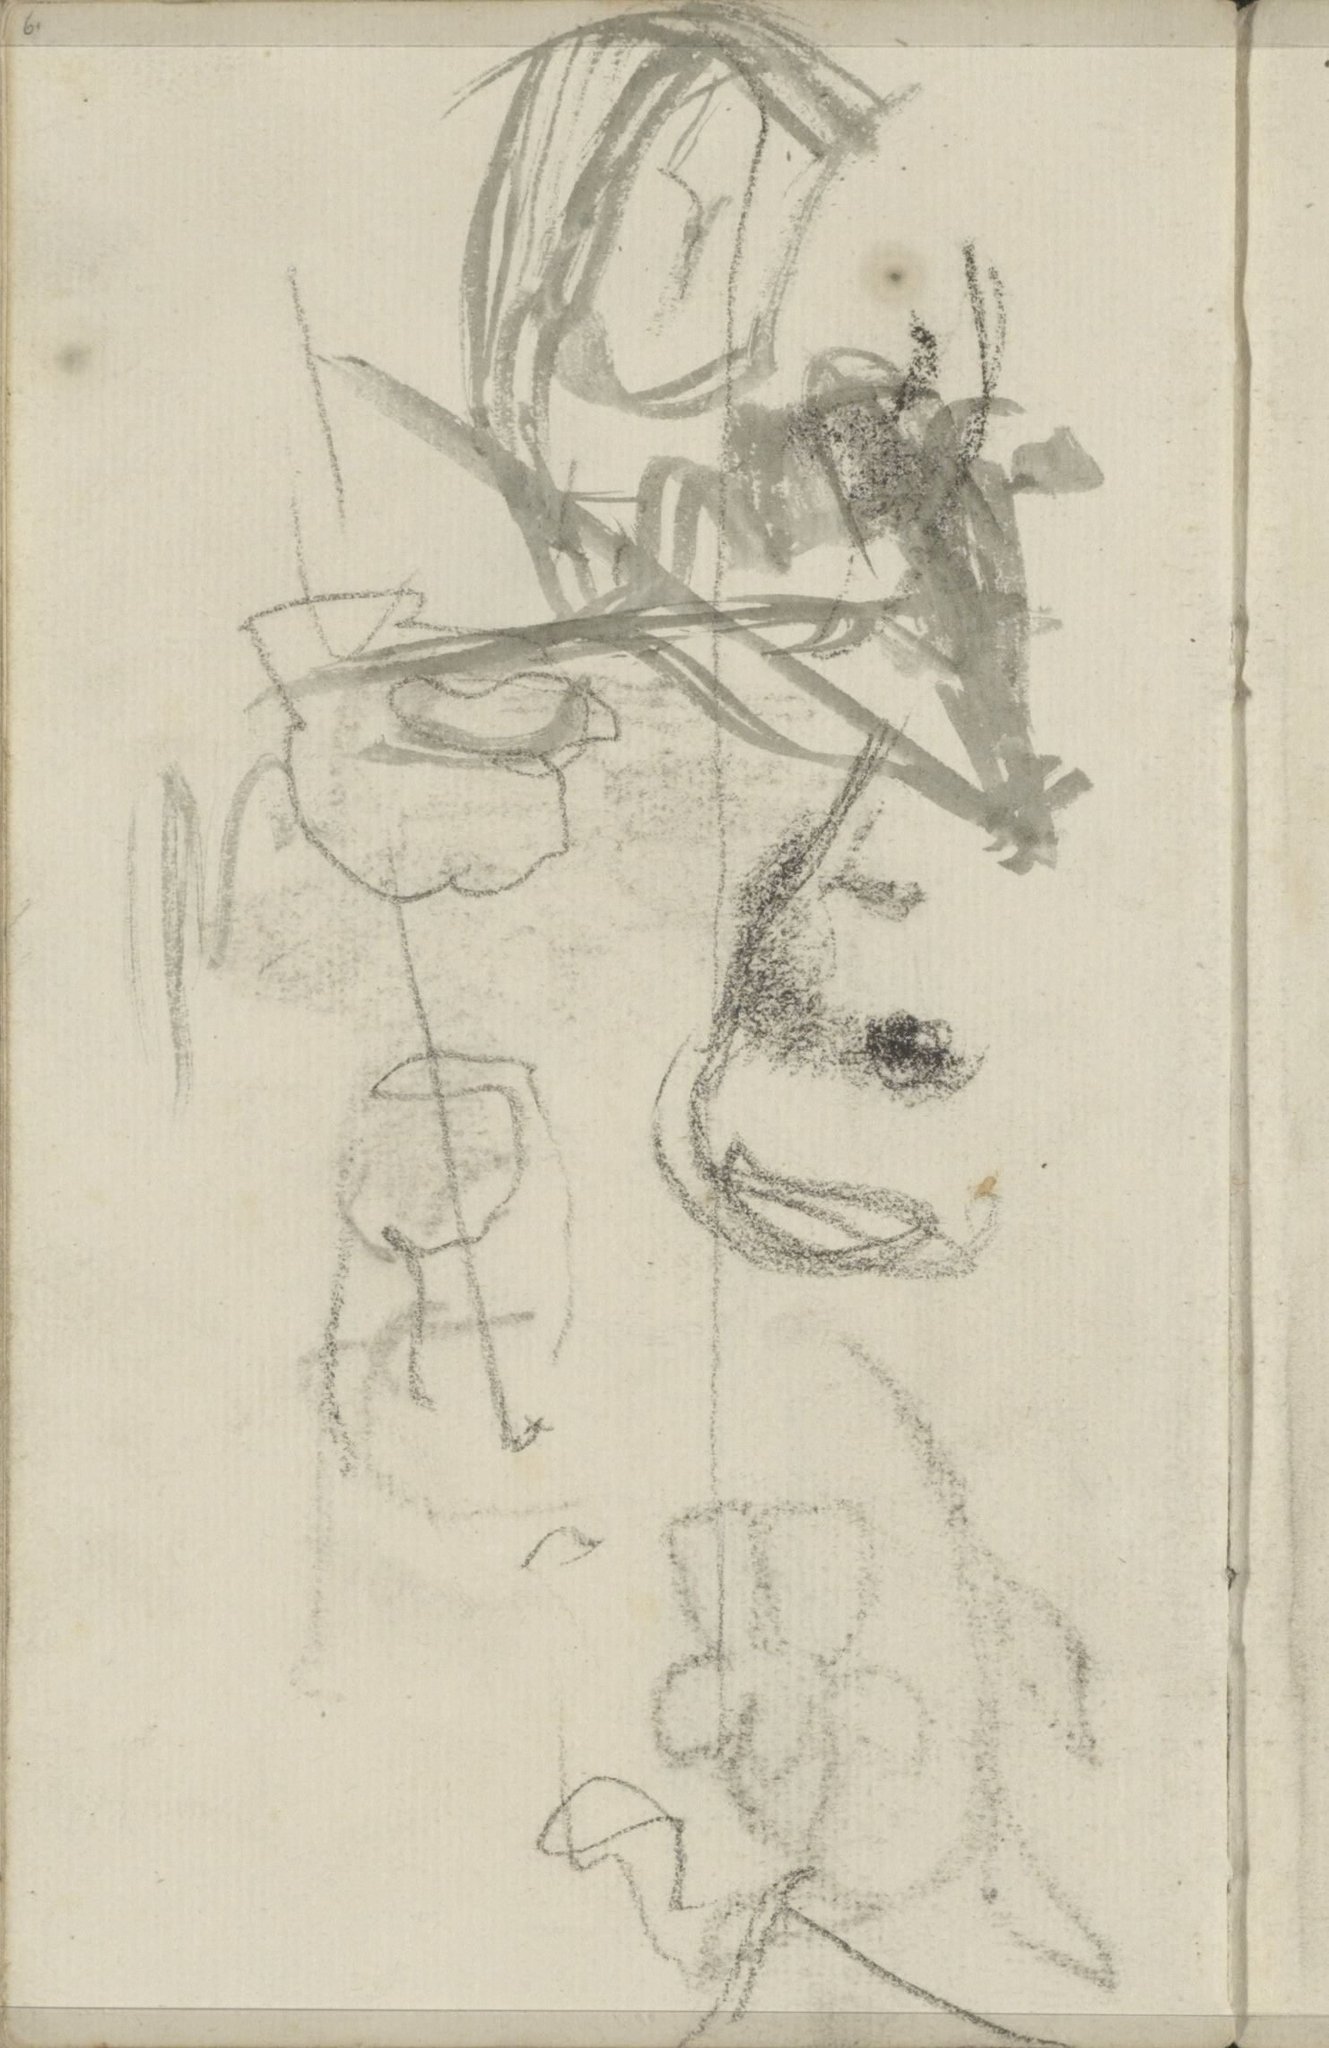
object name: sketchbook leaf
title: Studieblad, onder andere met een gezicht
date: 1880-1882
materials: chalk, paper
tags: face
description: Pagina 61 uit een schetsboek met 31 bladen.